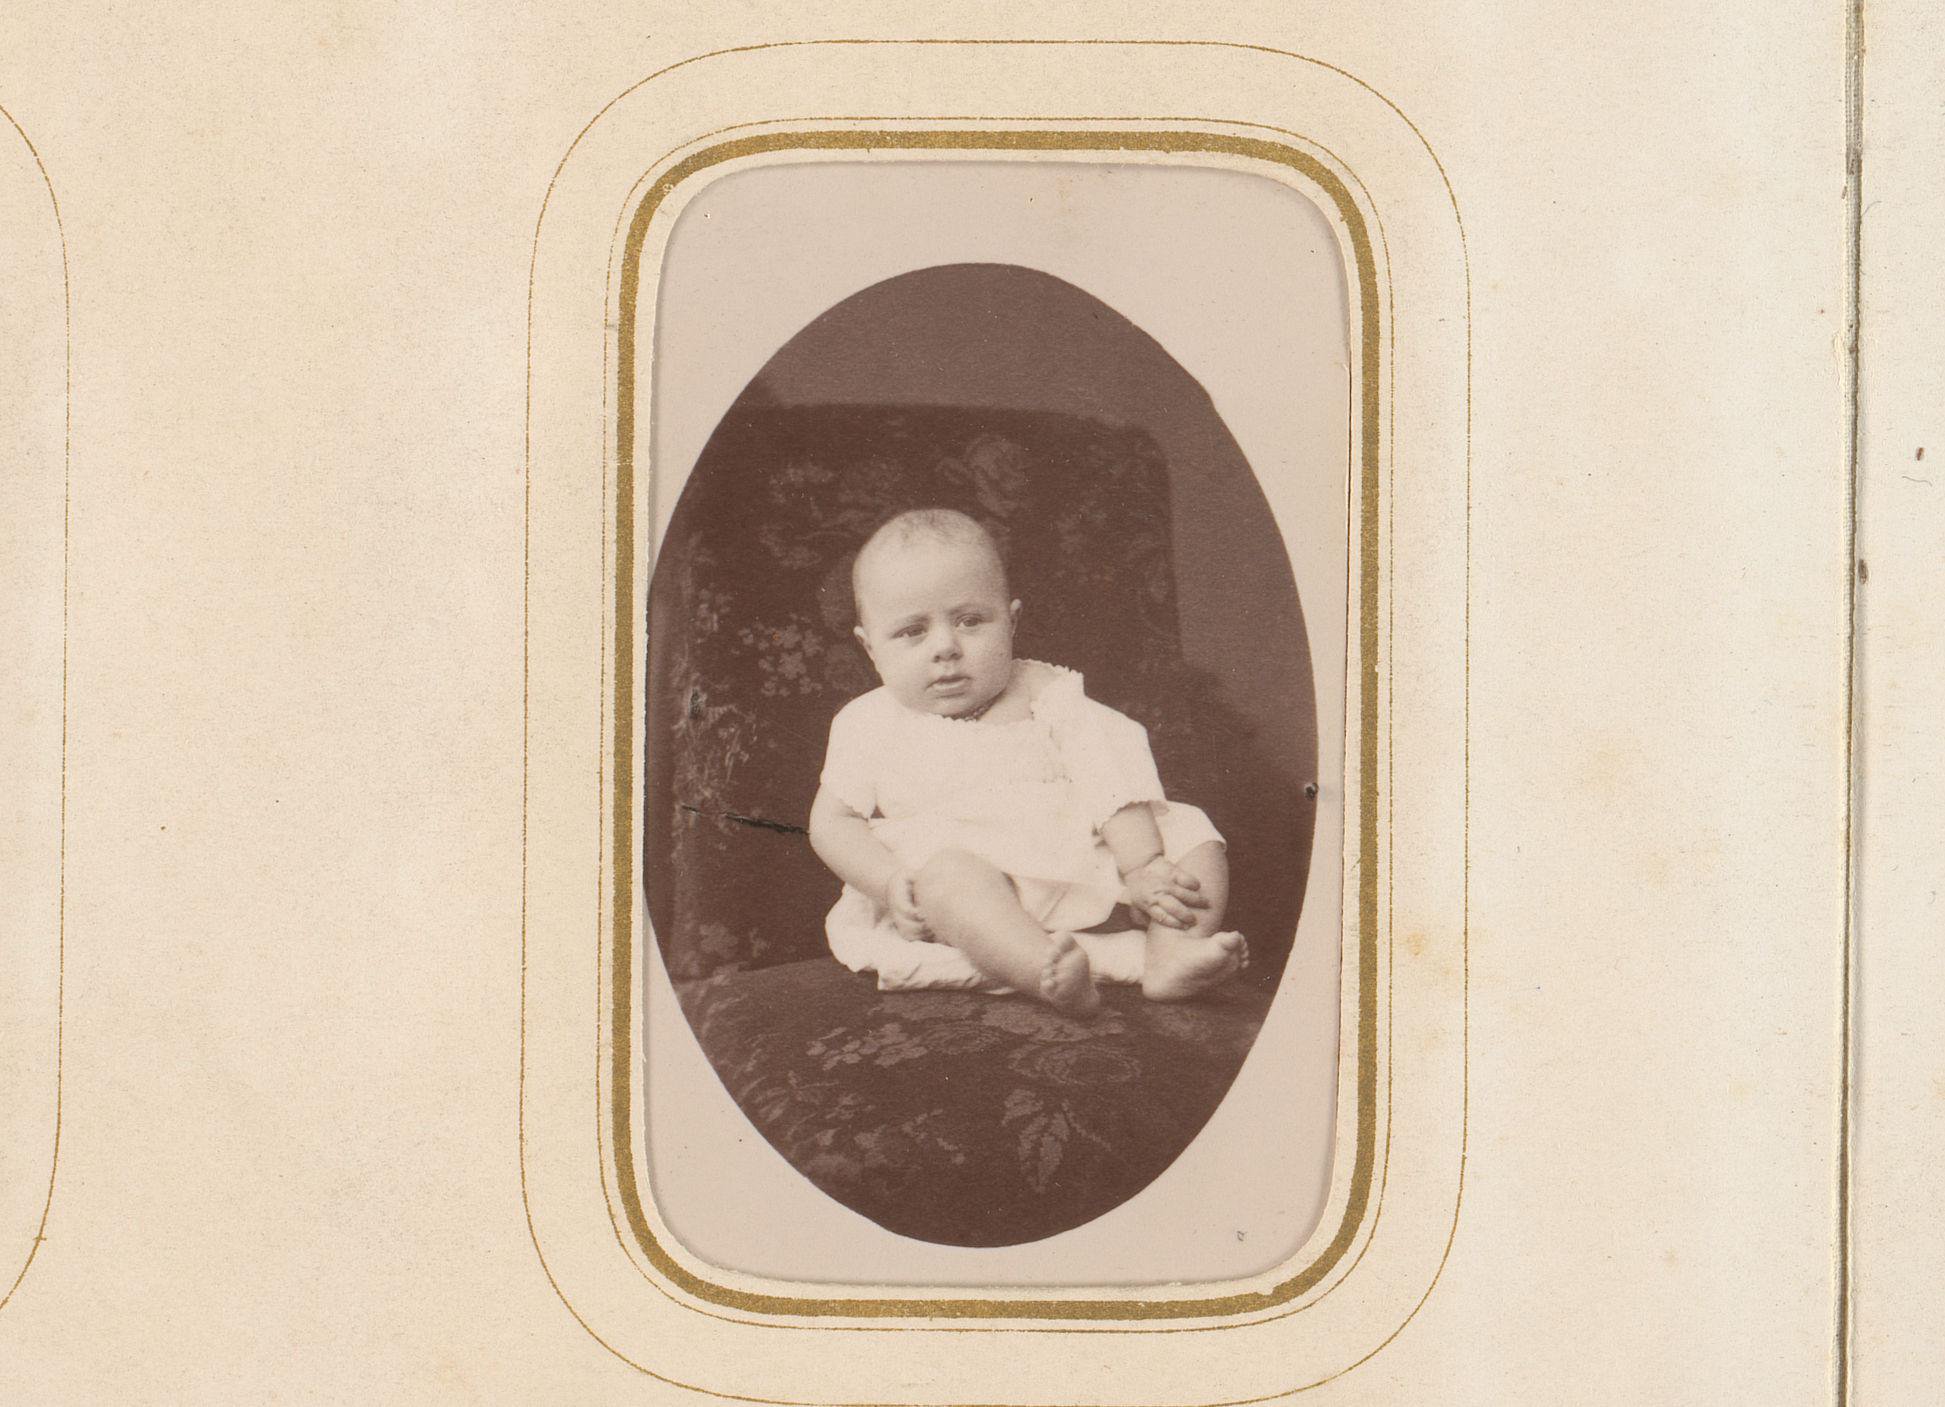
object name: photograph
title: Portret van een zittende baby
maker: Anonymous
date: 1880-1900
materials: cardboard, celluloid, photographic support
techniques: albumen print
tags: infant, baby